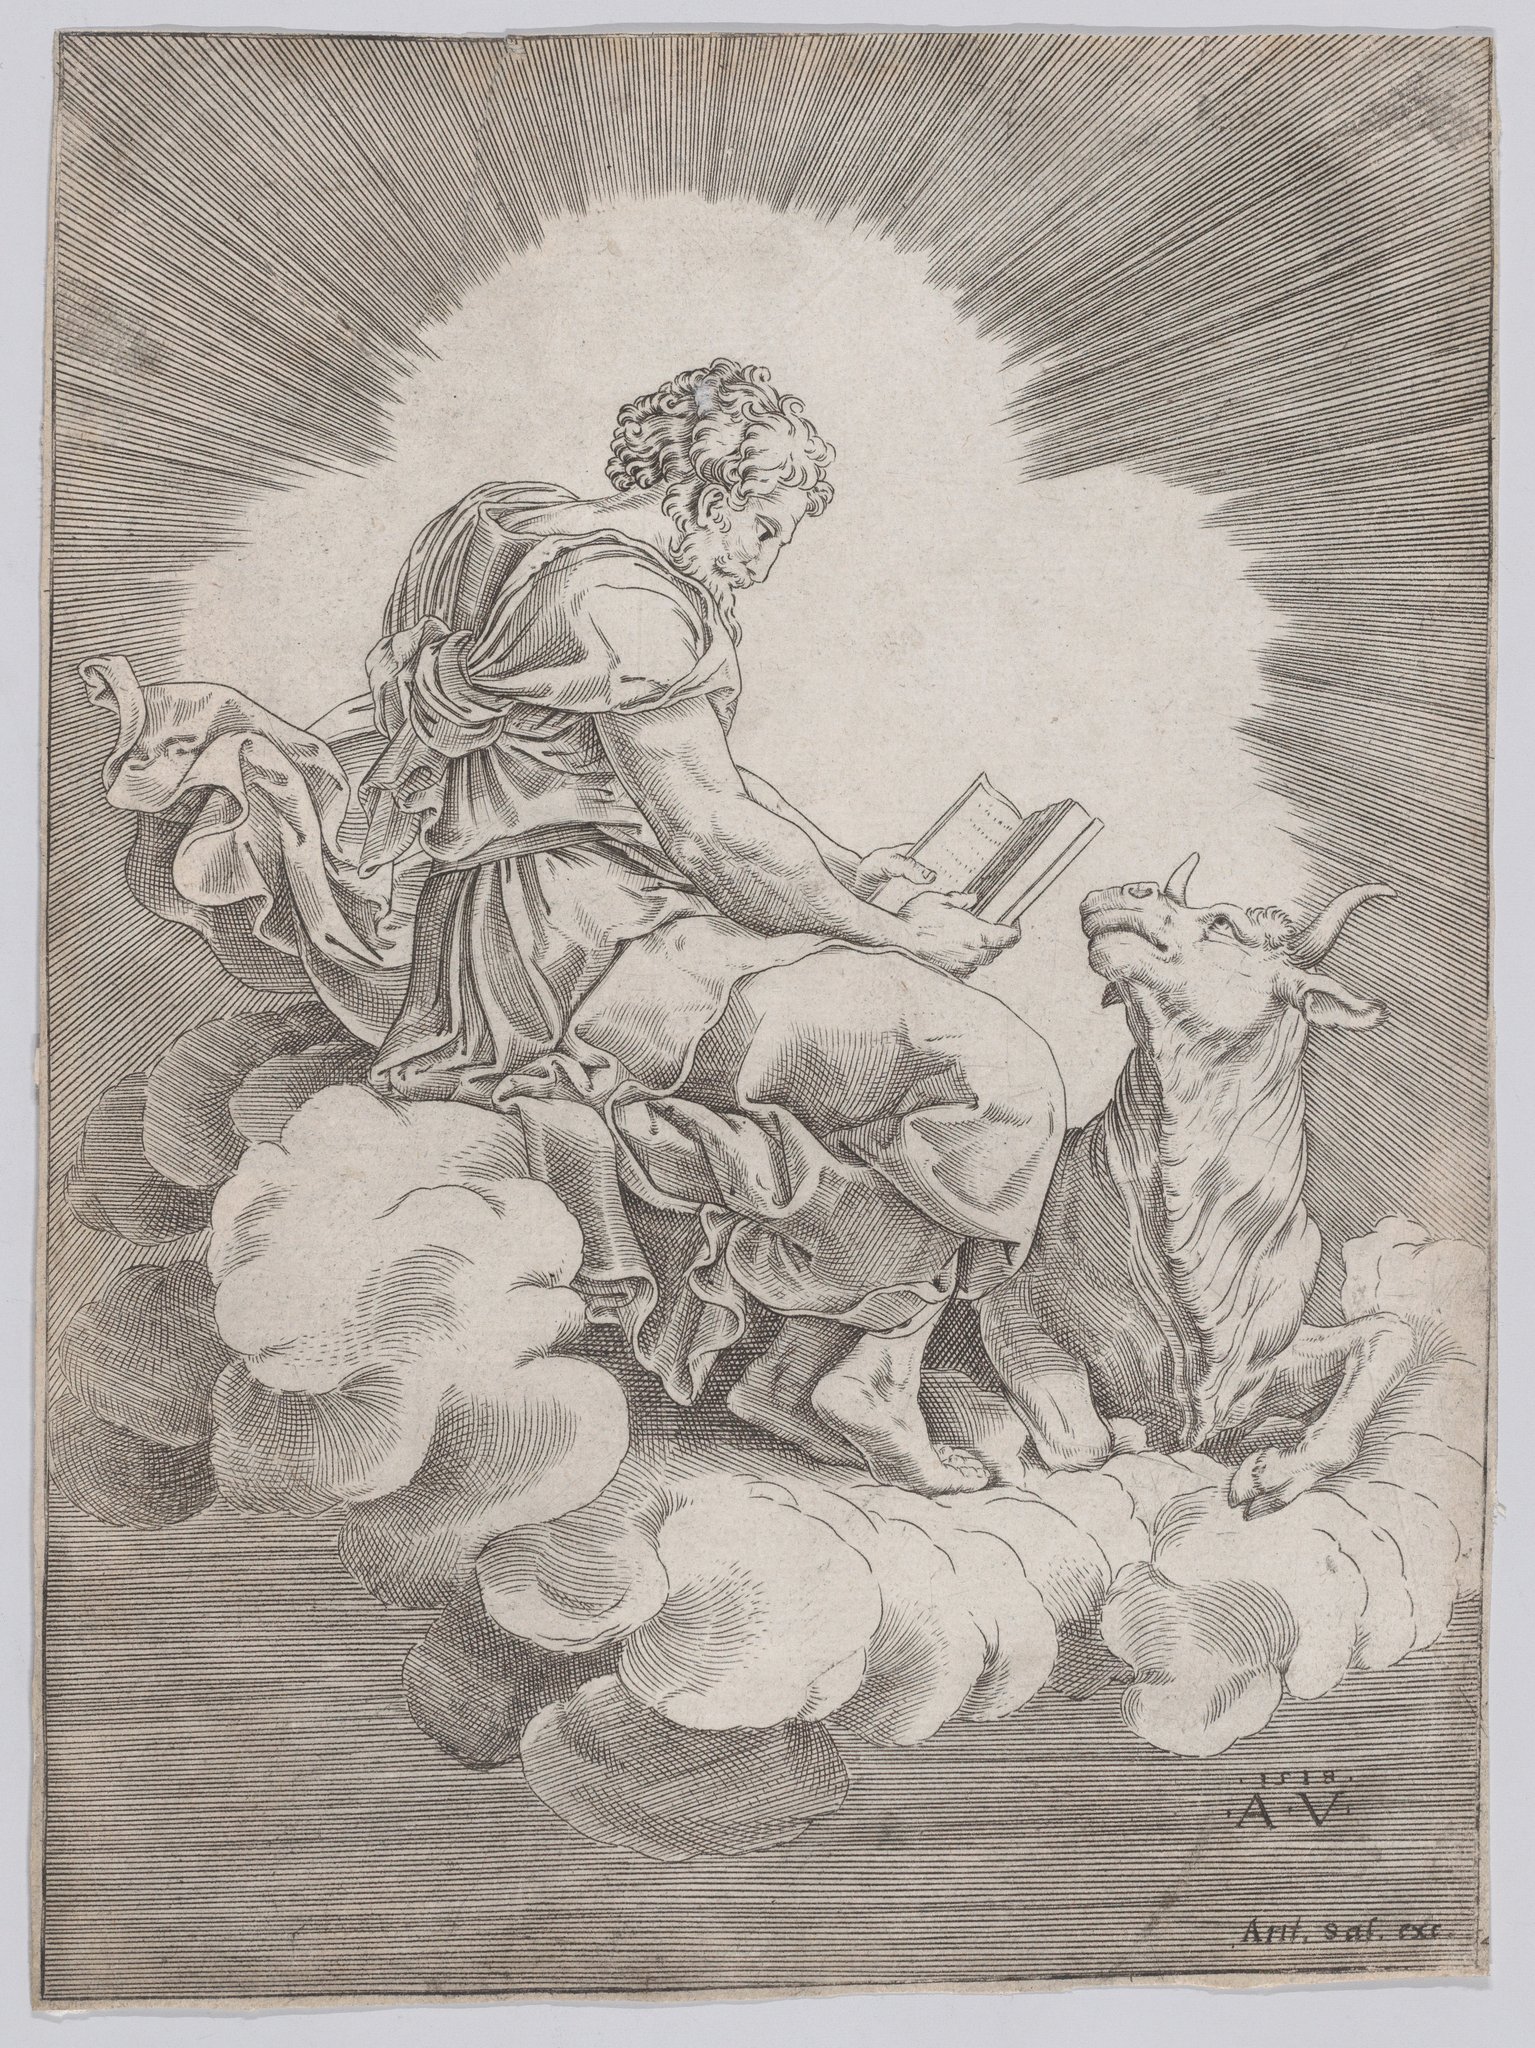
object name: print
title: Saint Luke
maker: agostino veneziano (agostino dei musi)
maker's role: artist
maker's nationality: italian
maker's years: 1490-1536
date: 1518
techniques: engraving